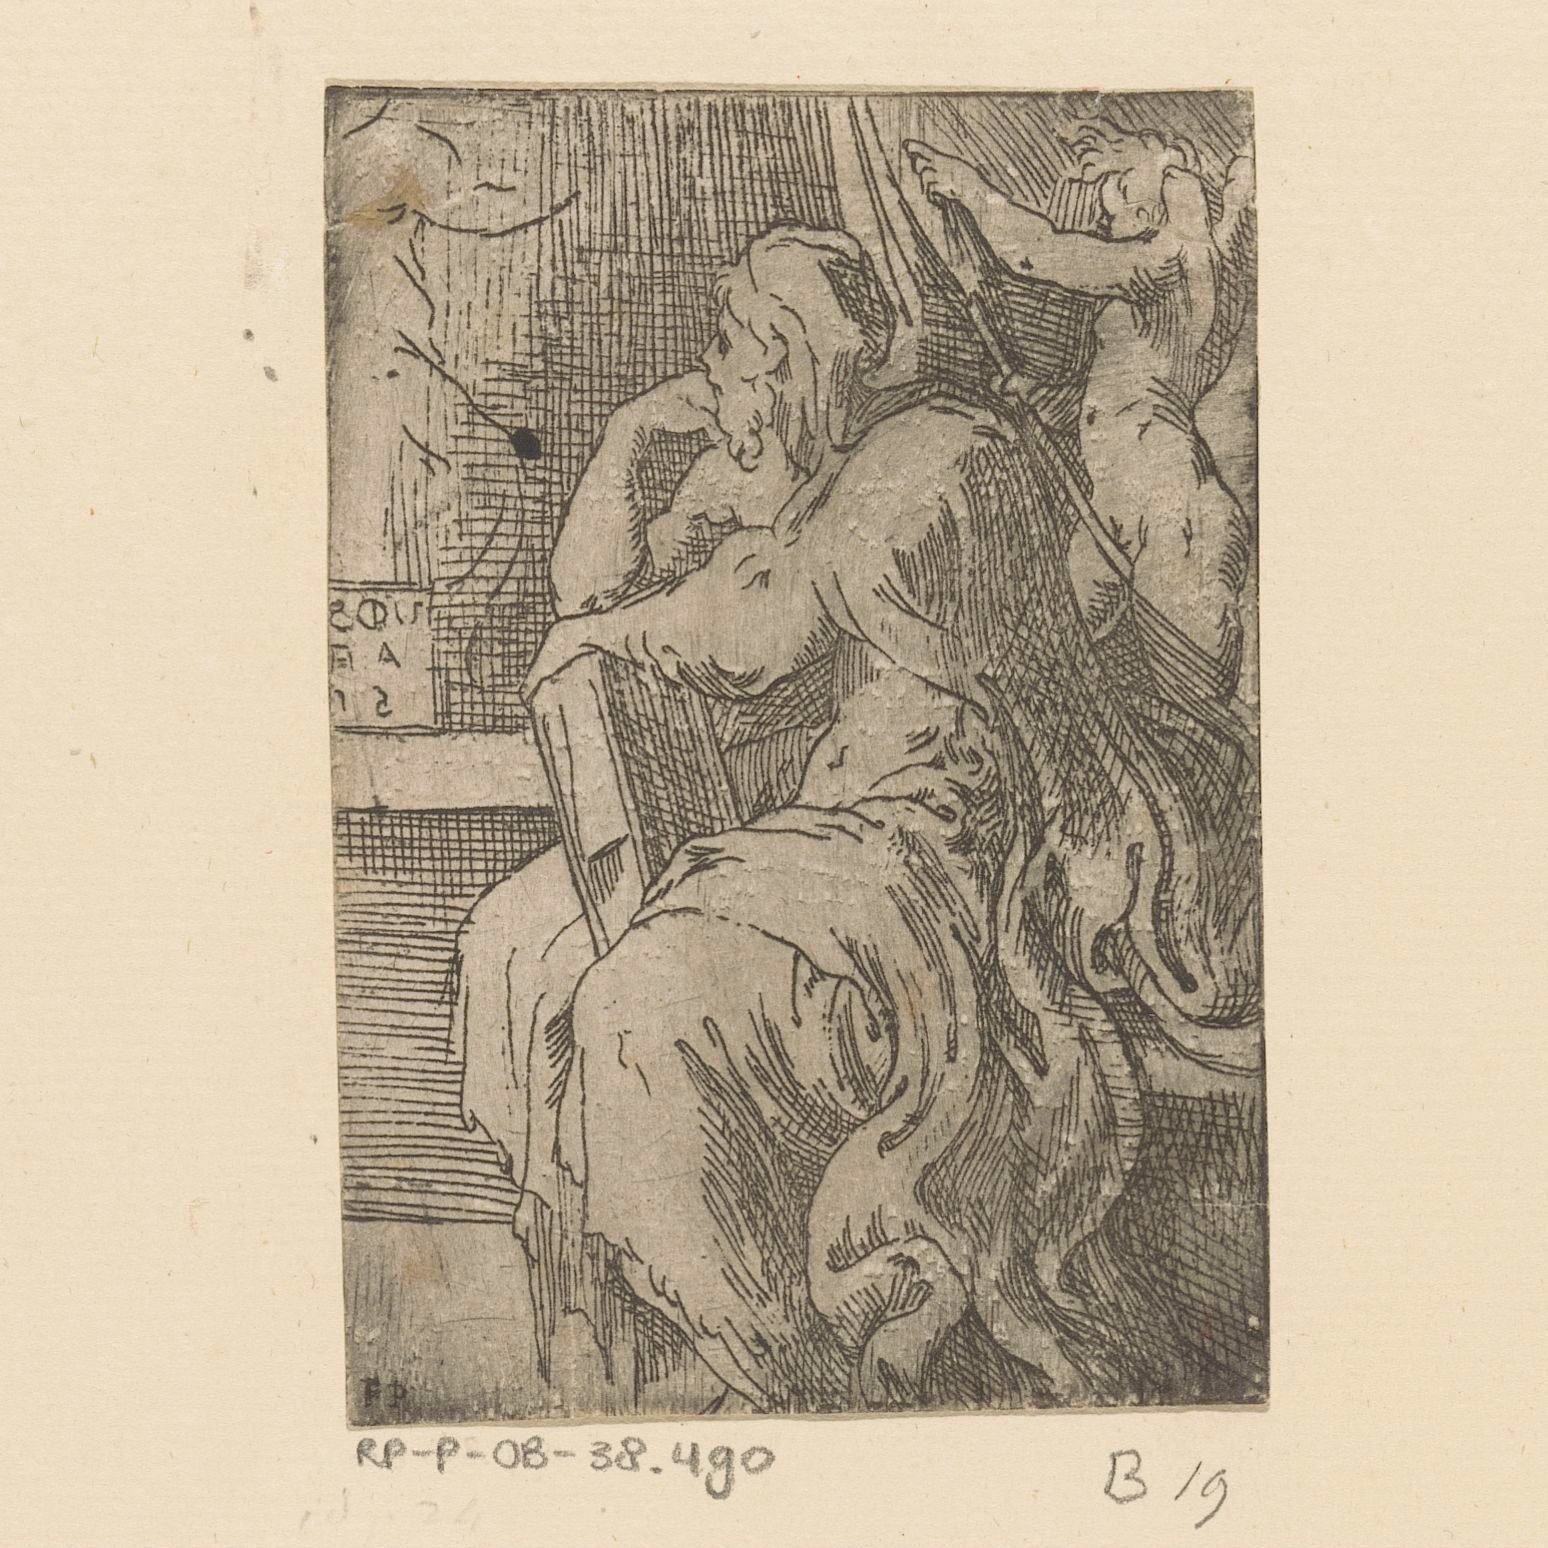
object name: print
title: Zittende filosoof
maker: monogrammist fp (italië; 16e eeuw)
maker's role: print maker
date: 1500-1599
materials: paper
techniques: etching, intaglio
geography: italy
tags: scholar, philosopher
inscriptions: collector's mark: Lugt 240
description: Een man met baard, zittend met een boek op schoot. Achter de man een putto.